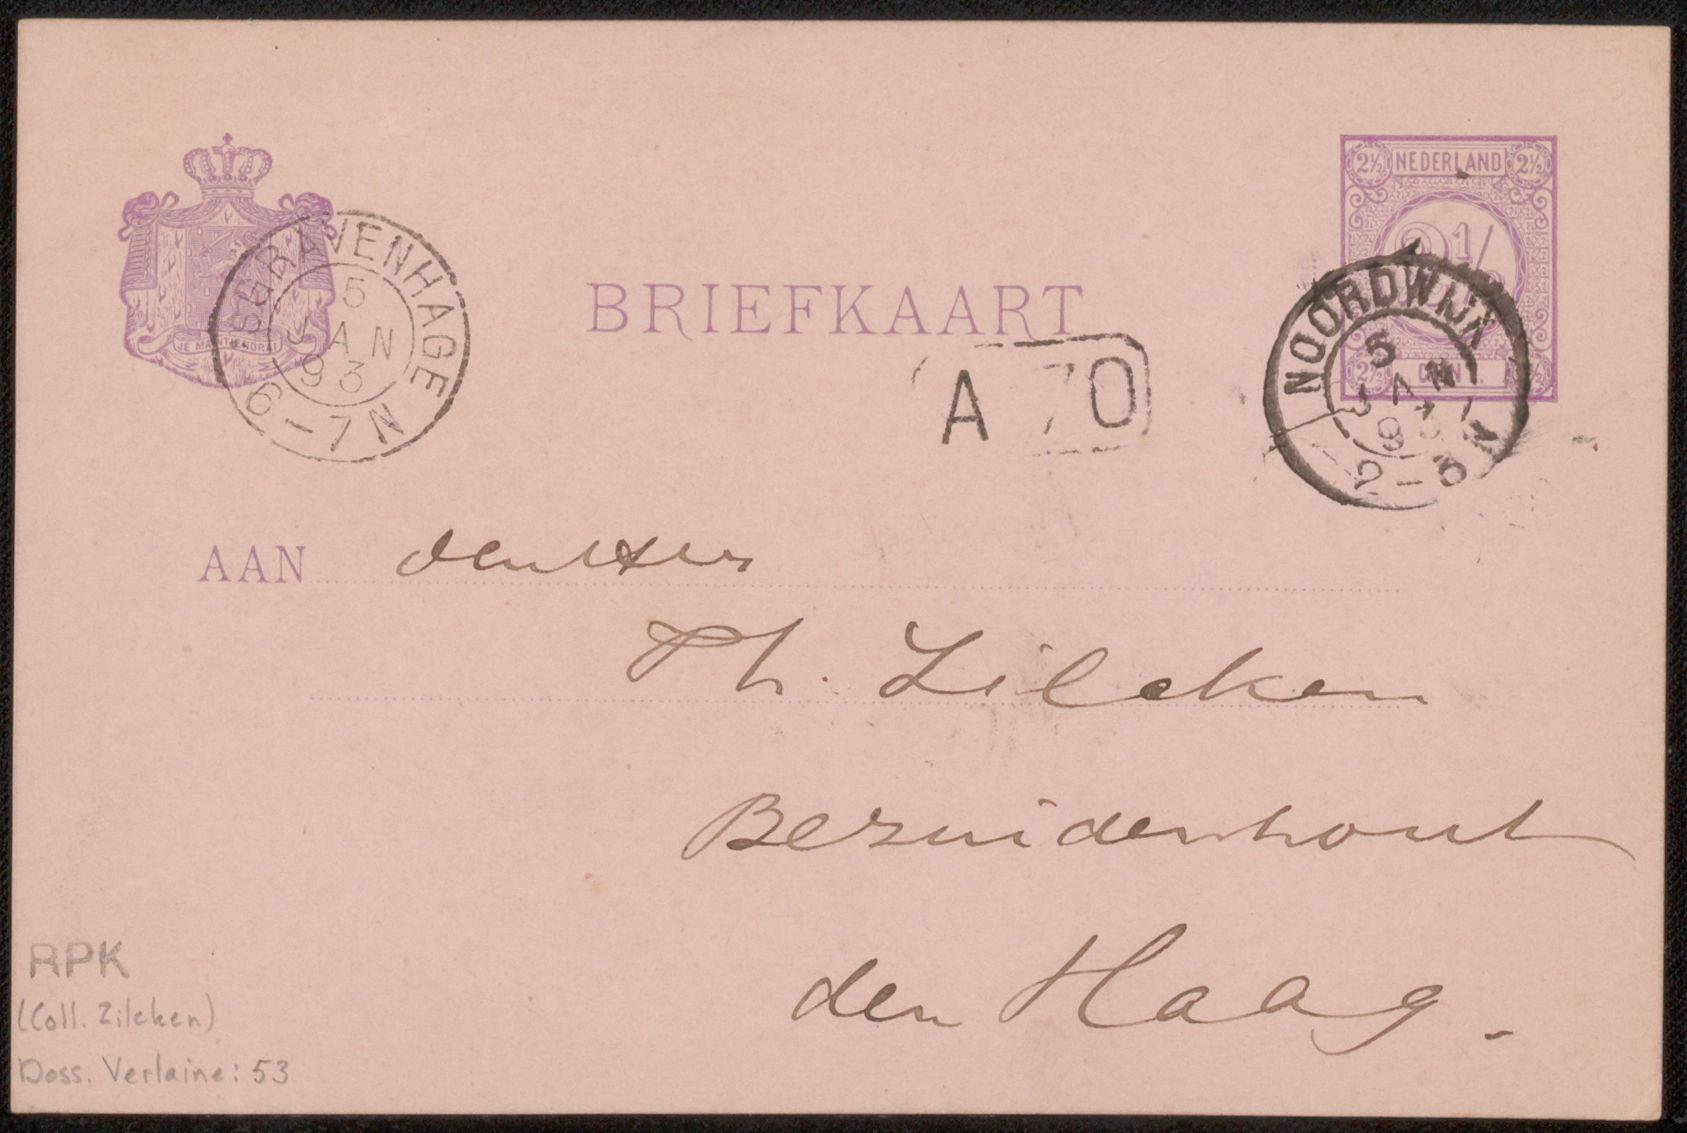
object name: postcard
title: Briefkaart aan Philip Zilcken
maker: albert verwey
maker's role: criticus, dichter, essayist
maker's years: 1865-1937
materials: cardboard, ink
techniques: pen, writing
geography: noordwijk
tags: painter, draughtsman, philip zilcken, photography, cinematography, rotterdam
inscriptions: collector's mark: ‘RPK’